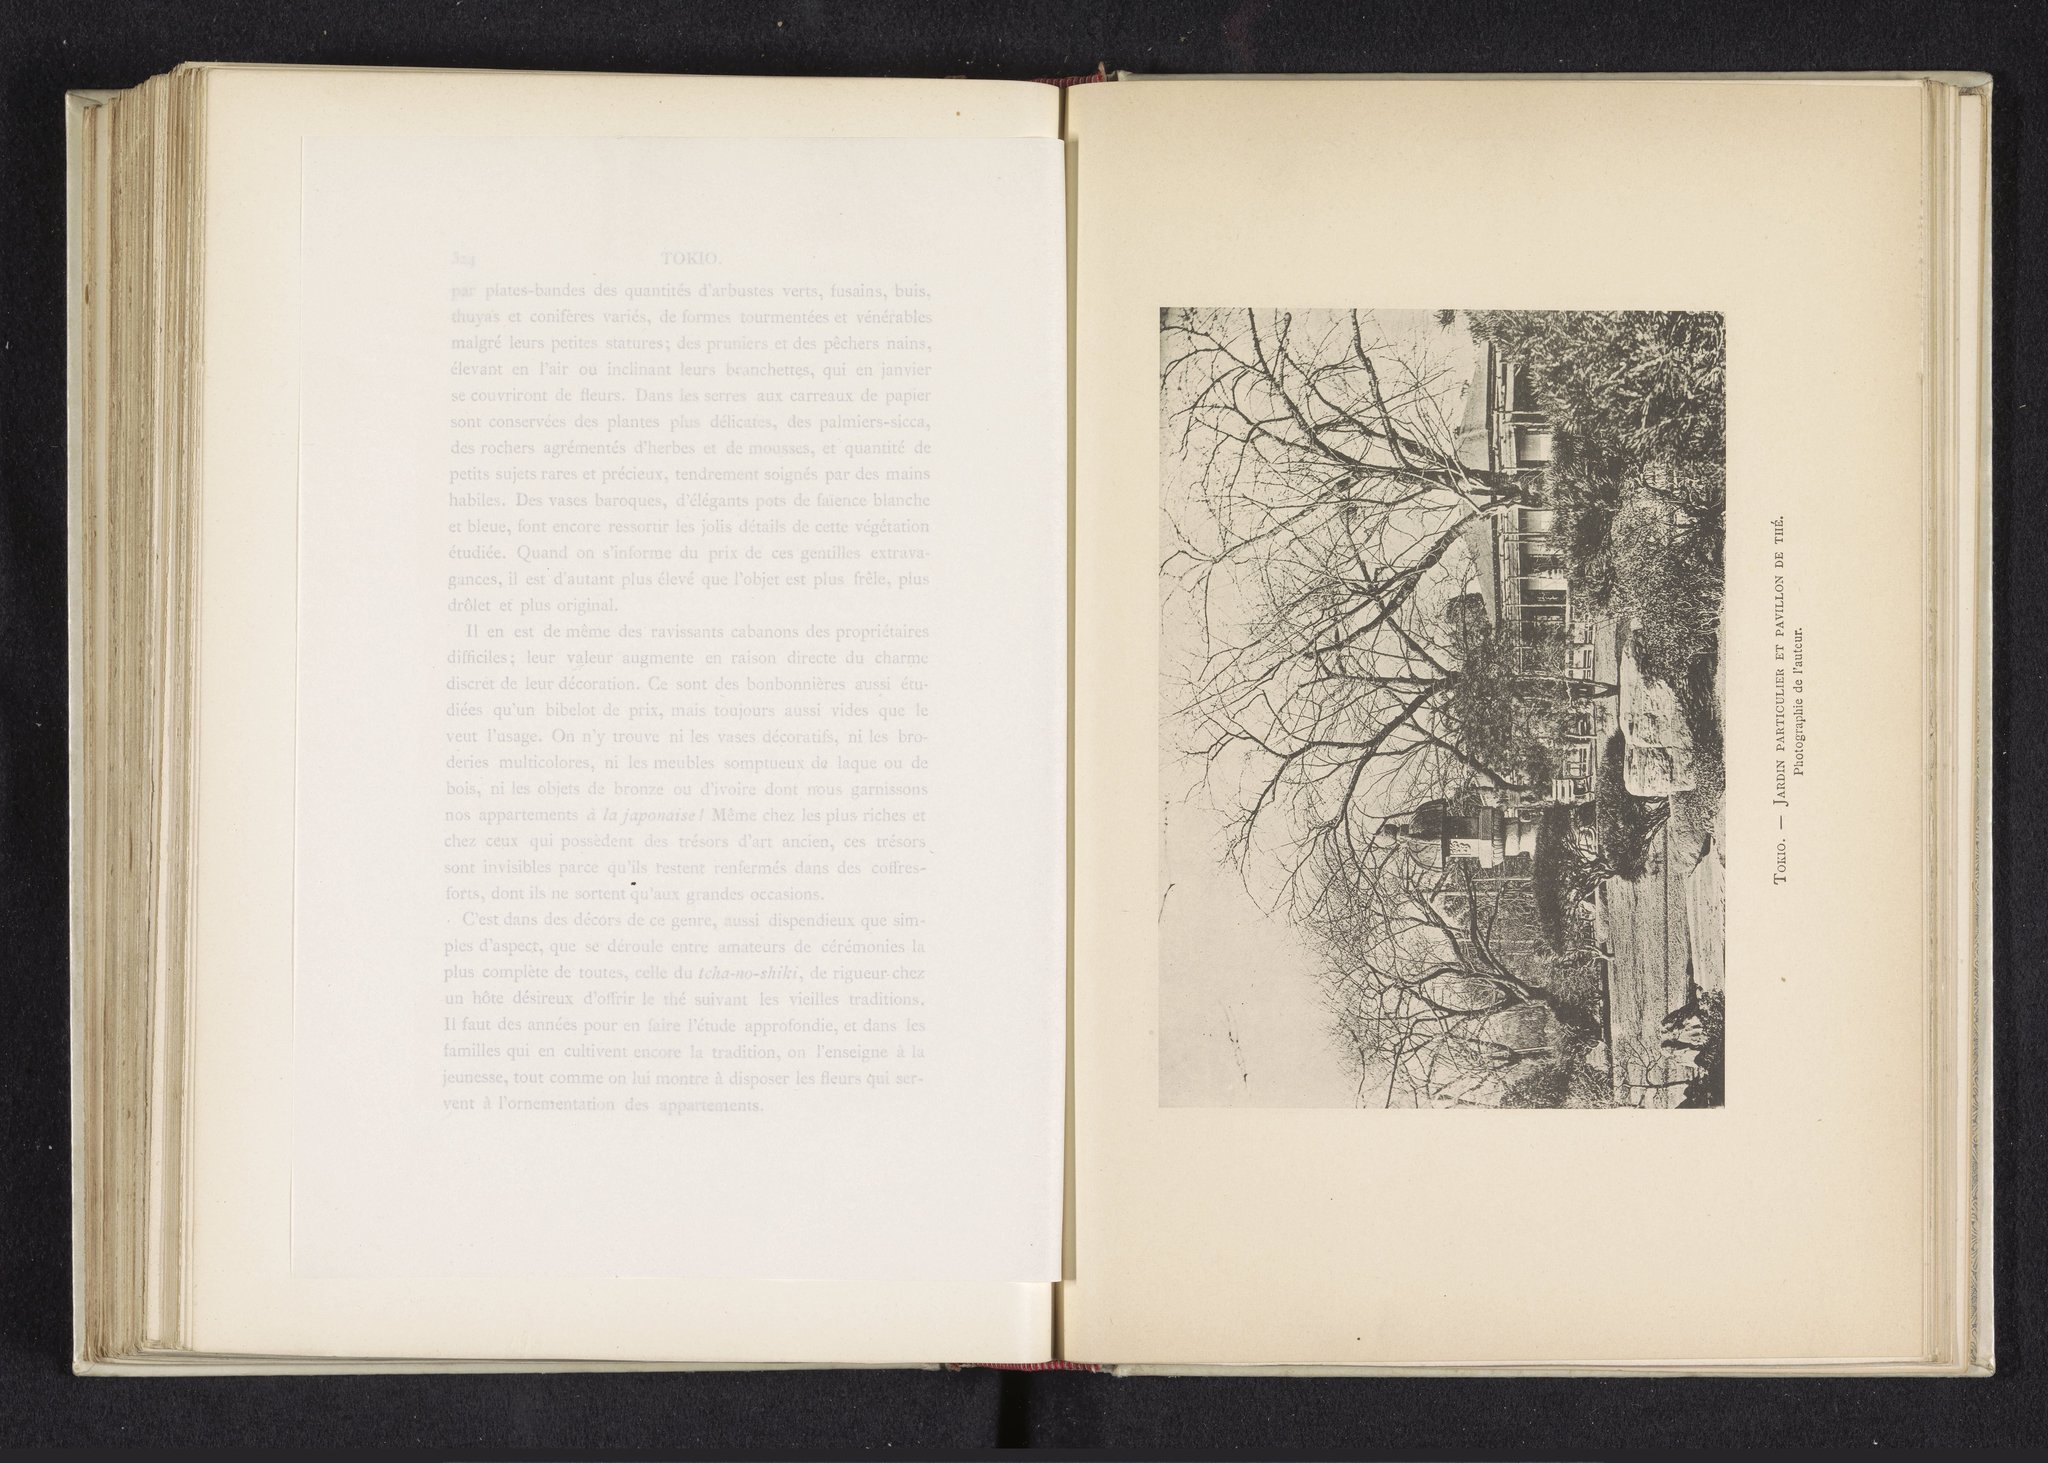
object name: page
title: Tokio. - Jardin particulier et pavillon de Thé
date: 1882-1883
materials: paper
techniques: photograph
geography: tokyo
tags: garden, lantern, façade (of house or building)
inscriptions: inscription: ‘Photographie de l'auteur.’